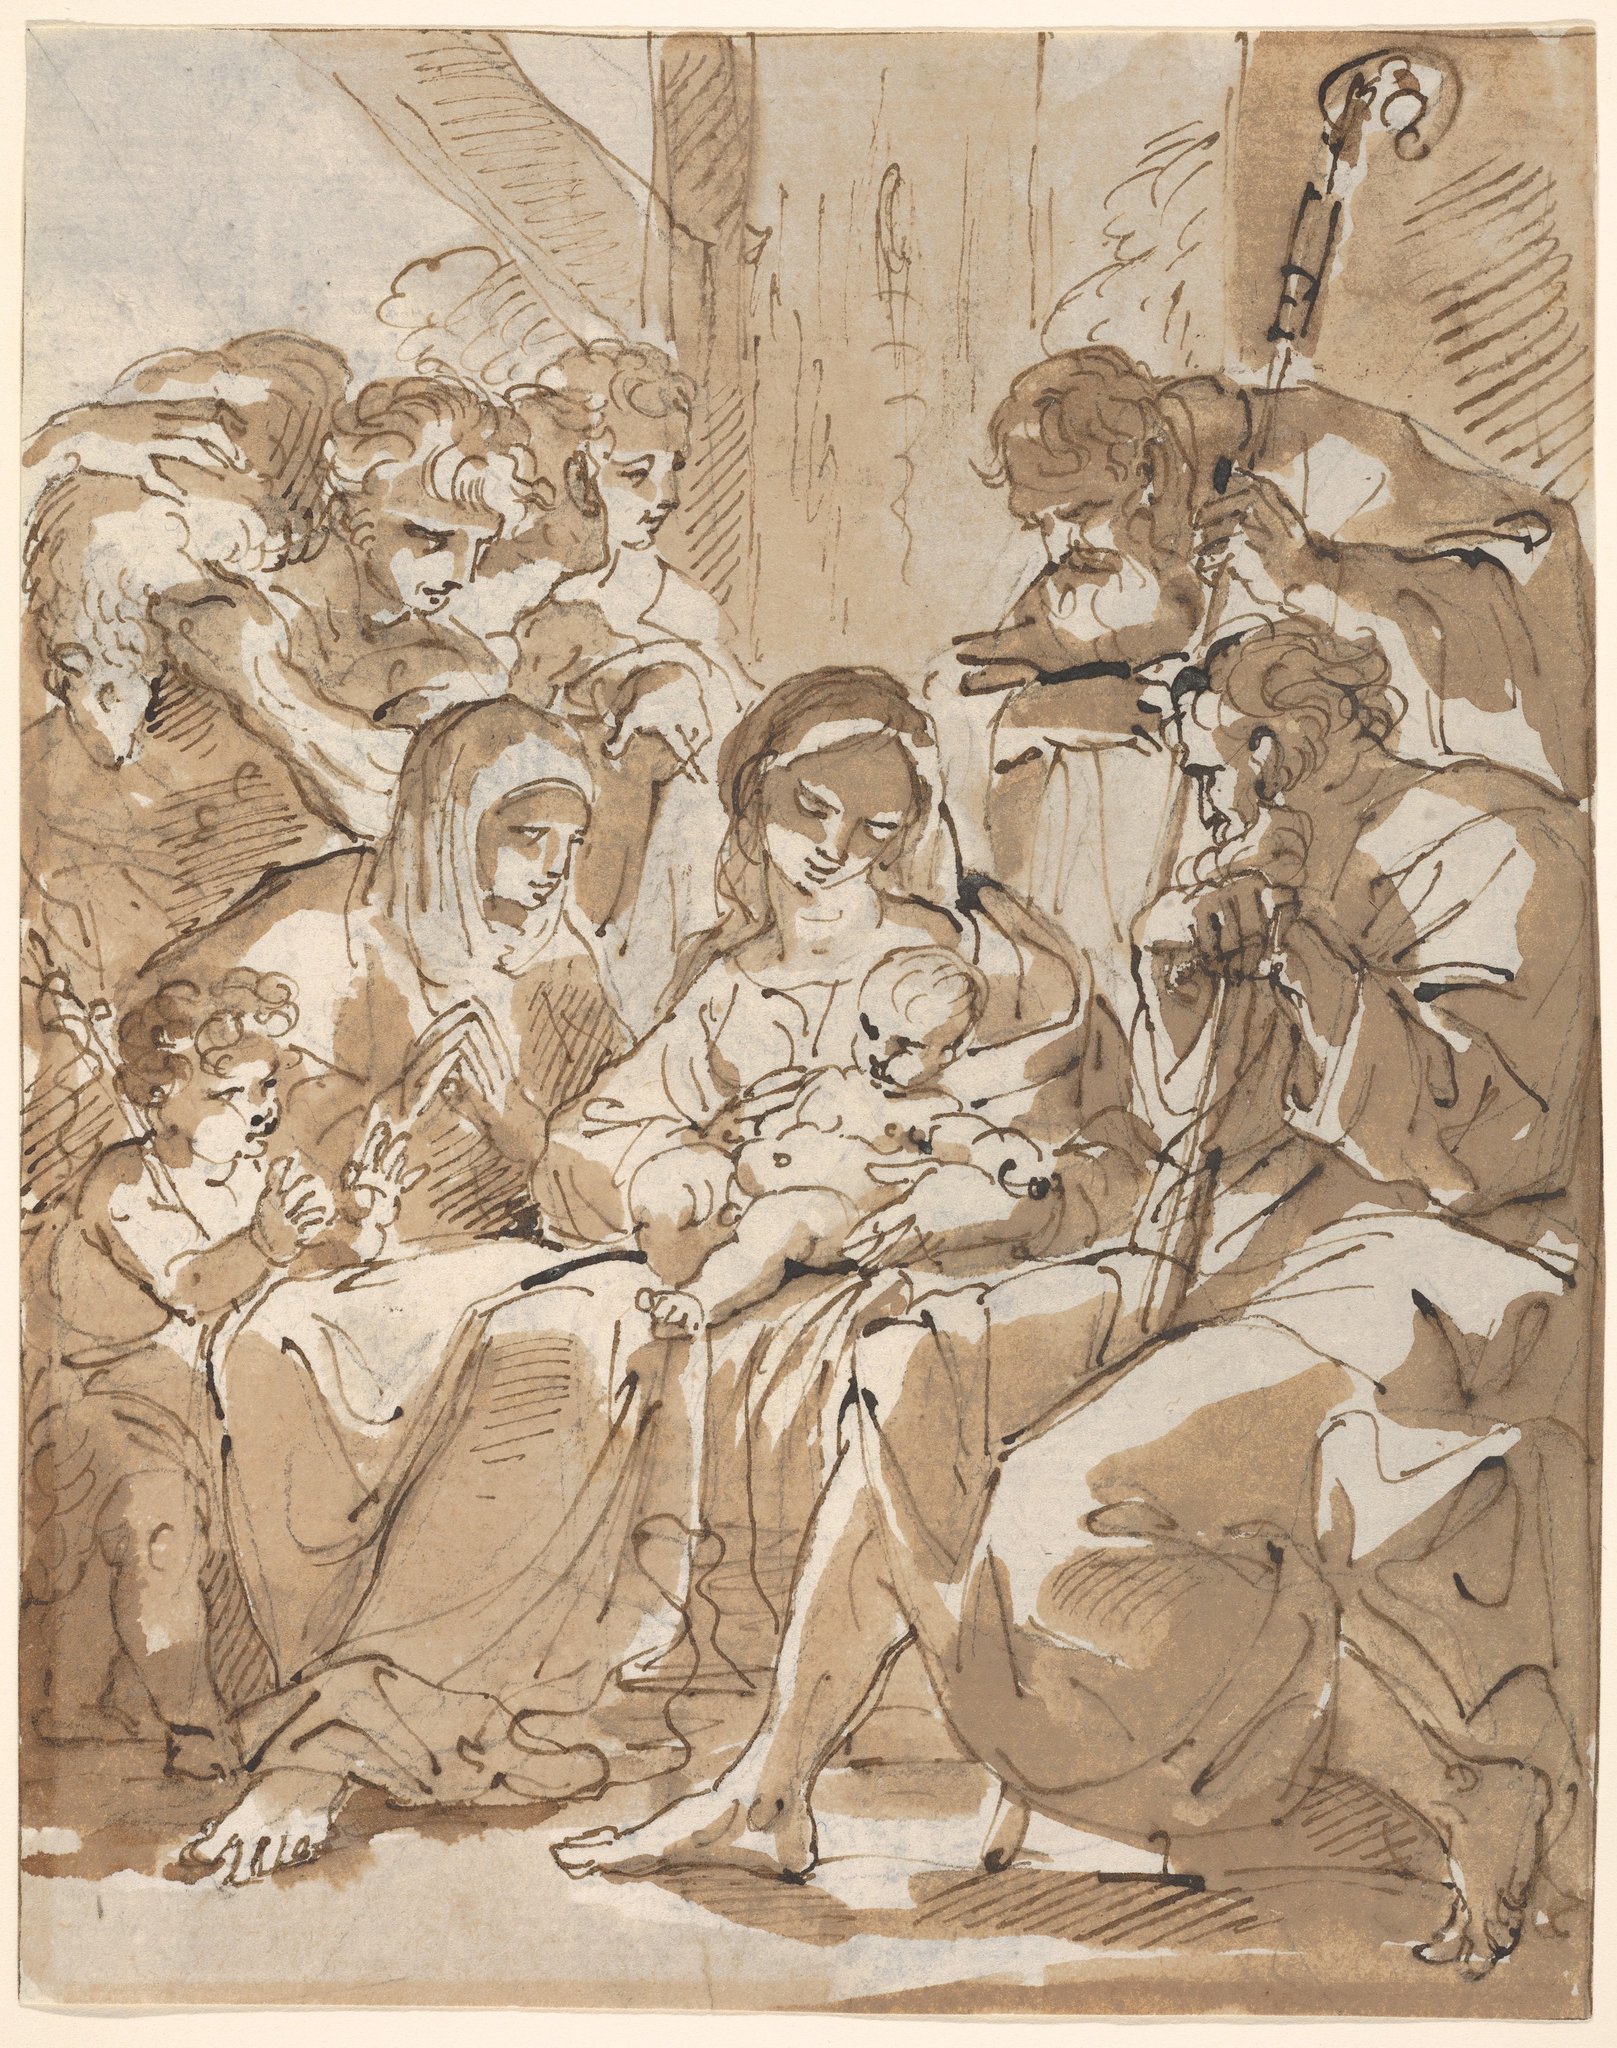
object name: drawing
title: Adoration of the Shepherds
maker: ubaldo gandolfi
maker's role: artist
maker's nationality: italian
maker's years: 1728-1781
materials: chalk, ink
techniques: pen, wash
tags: virgin mary,jesus,adoration of the shepherds,shepherds